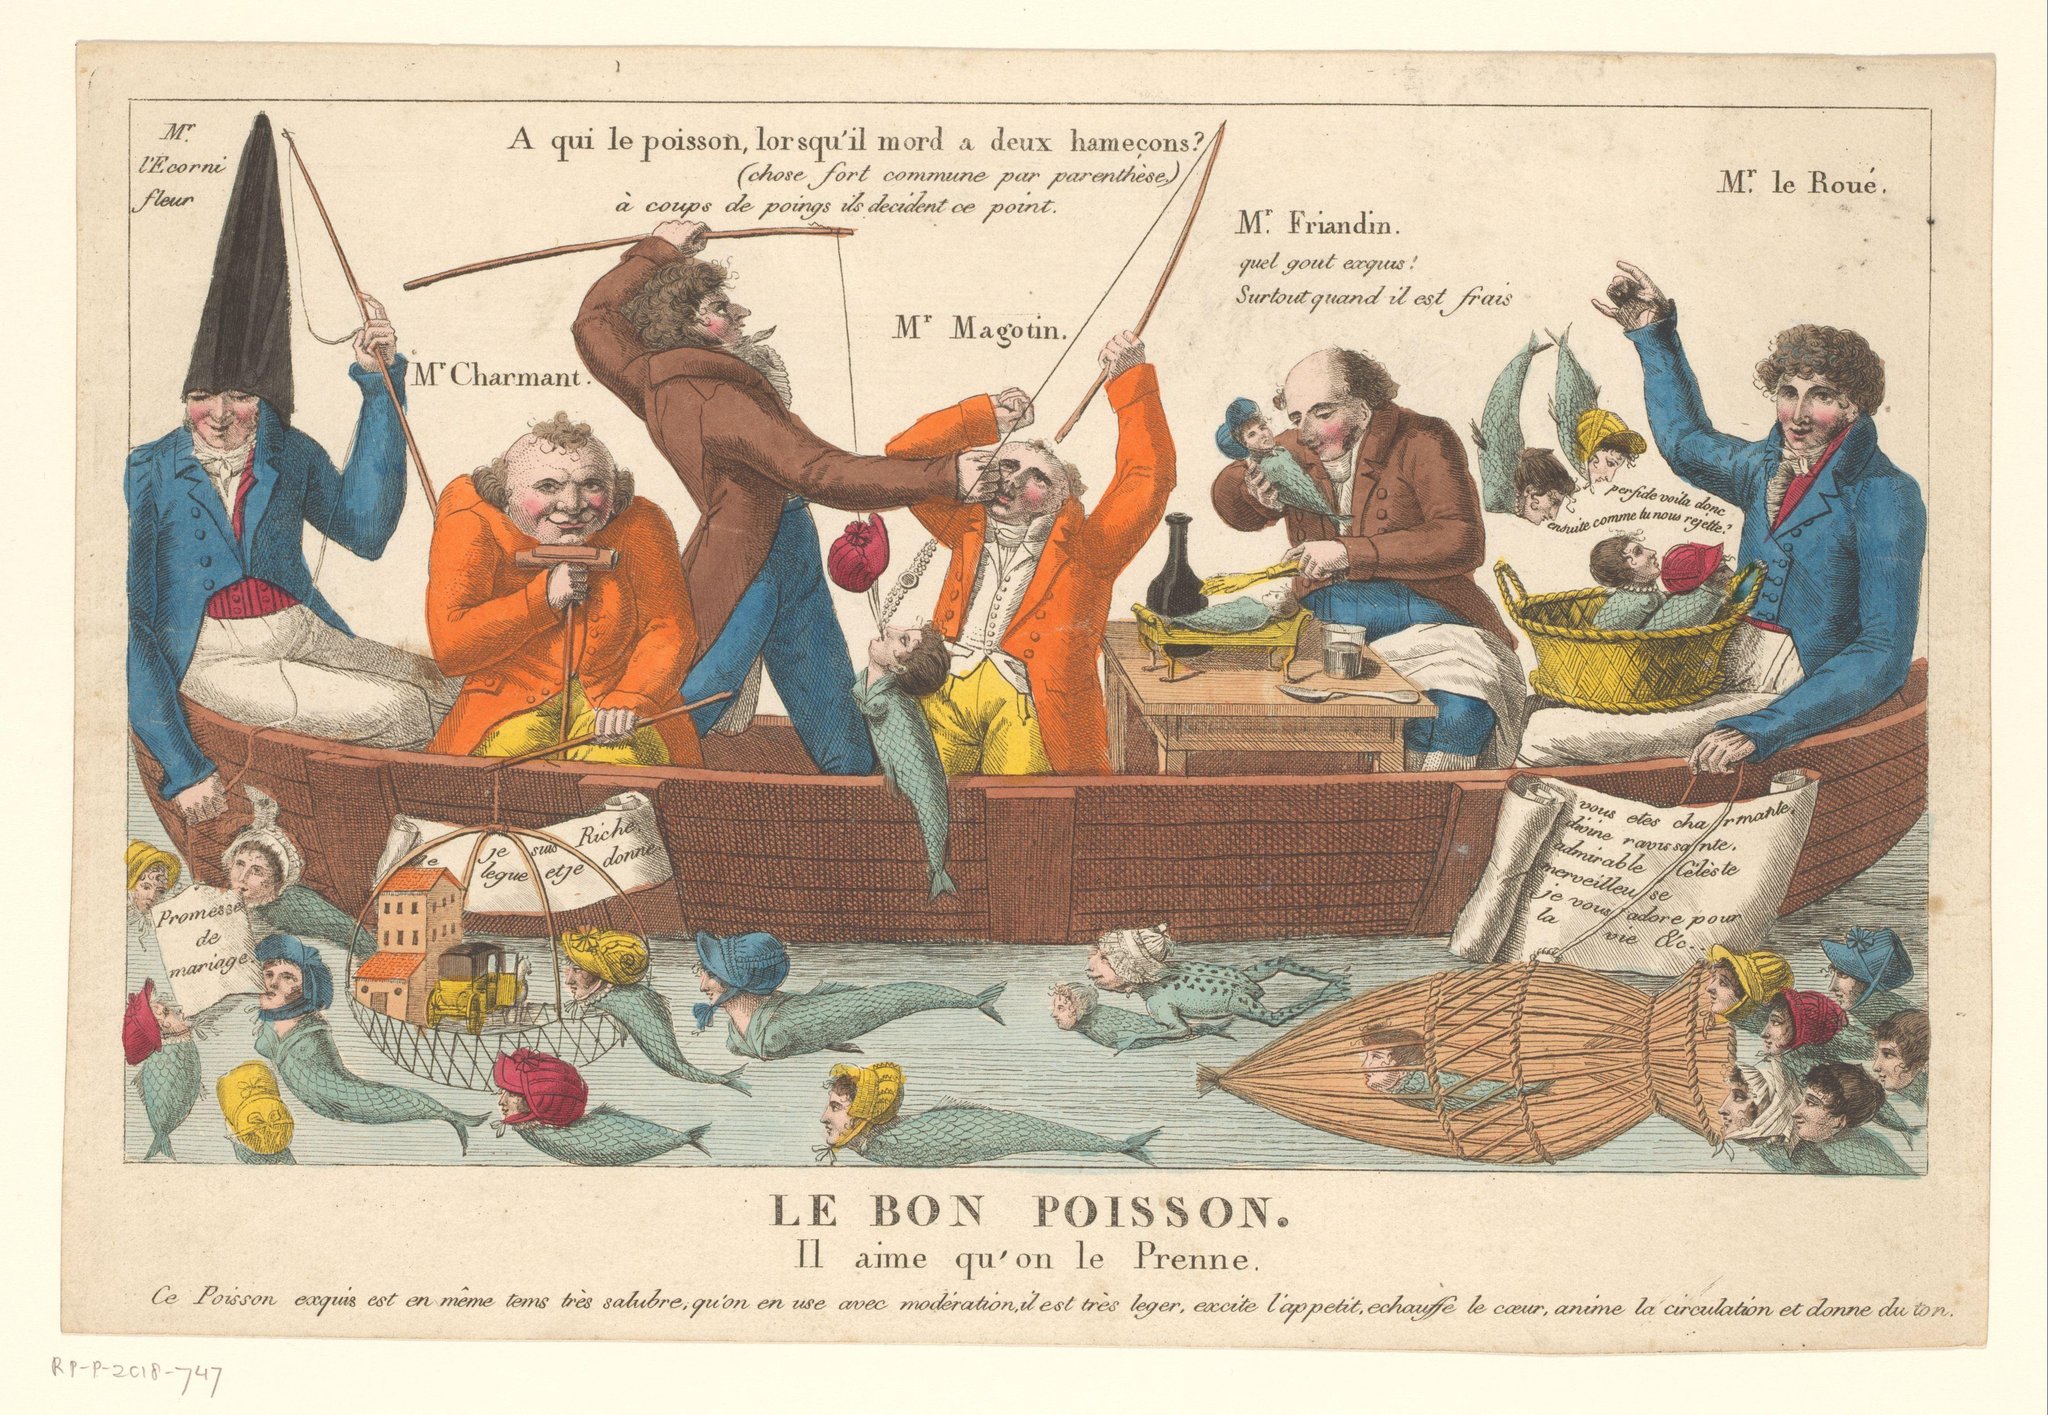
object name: print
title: Mannen vissen op vrouwen, ca. 1820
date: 1810-1830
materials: paper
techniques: etching, hand coloring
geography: paris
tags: fishes, monsters ~ fishes, courting, angling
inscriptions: collector's mark: Lugt 2228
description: Spotprent met een boot vol mannen die met hengels en fuiken vrouwen, voorgesteld als vissen, proberen te vangen. Zie ook de pendant.